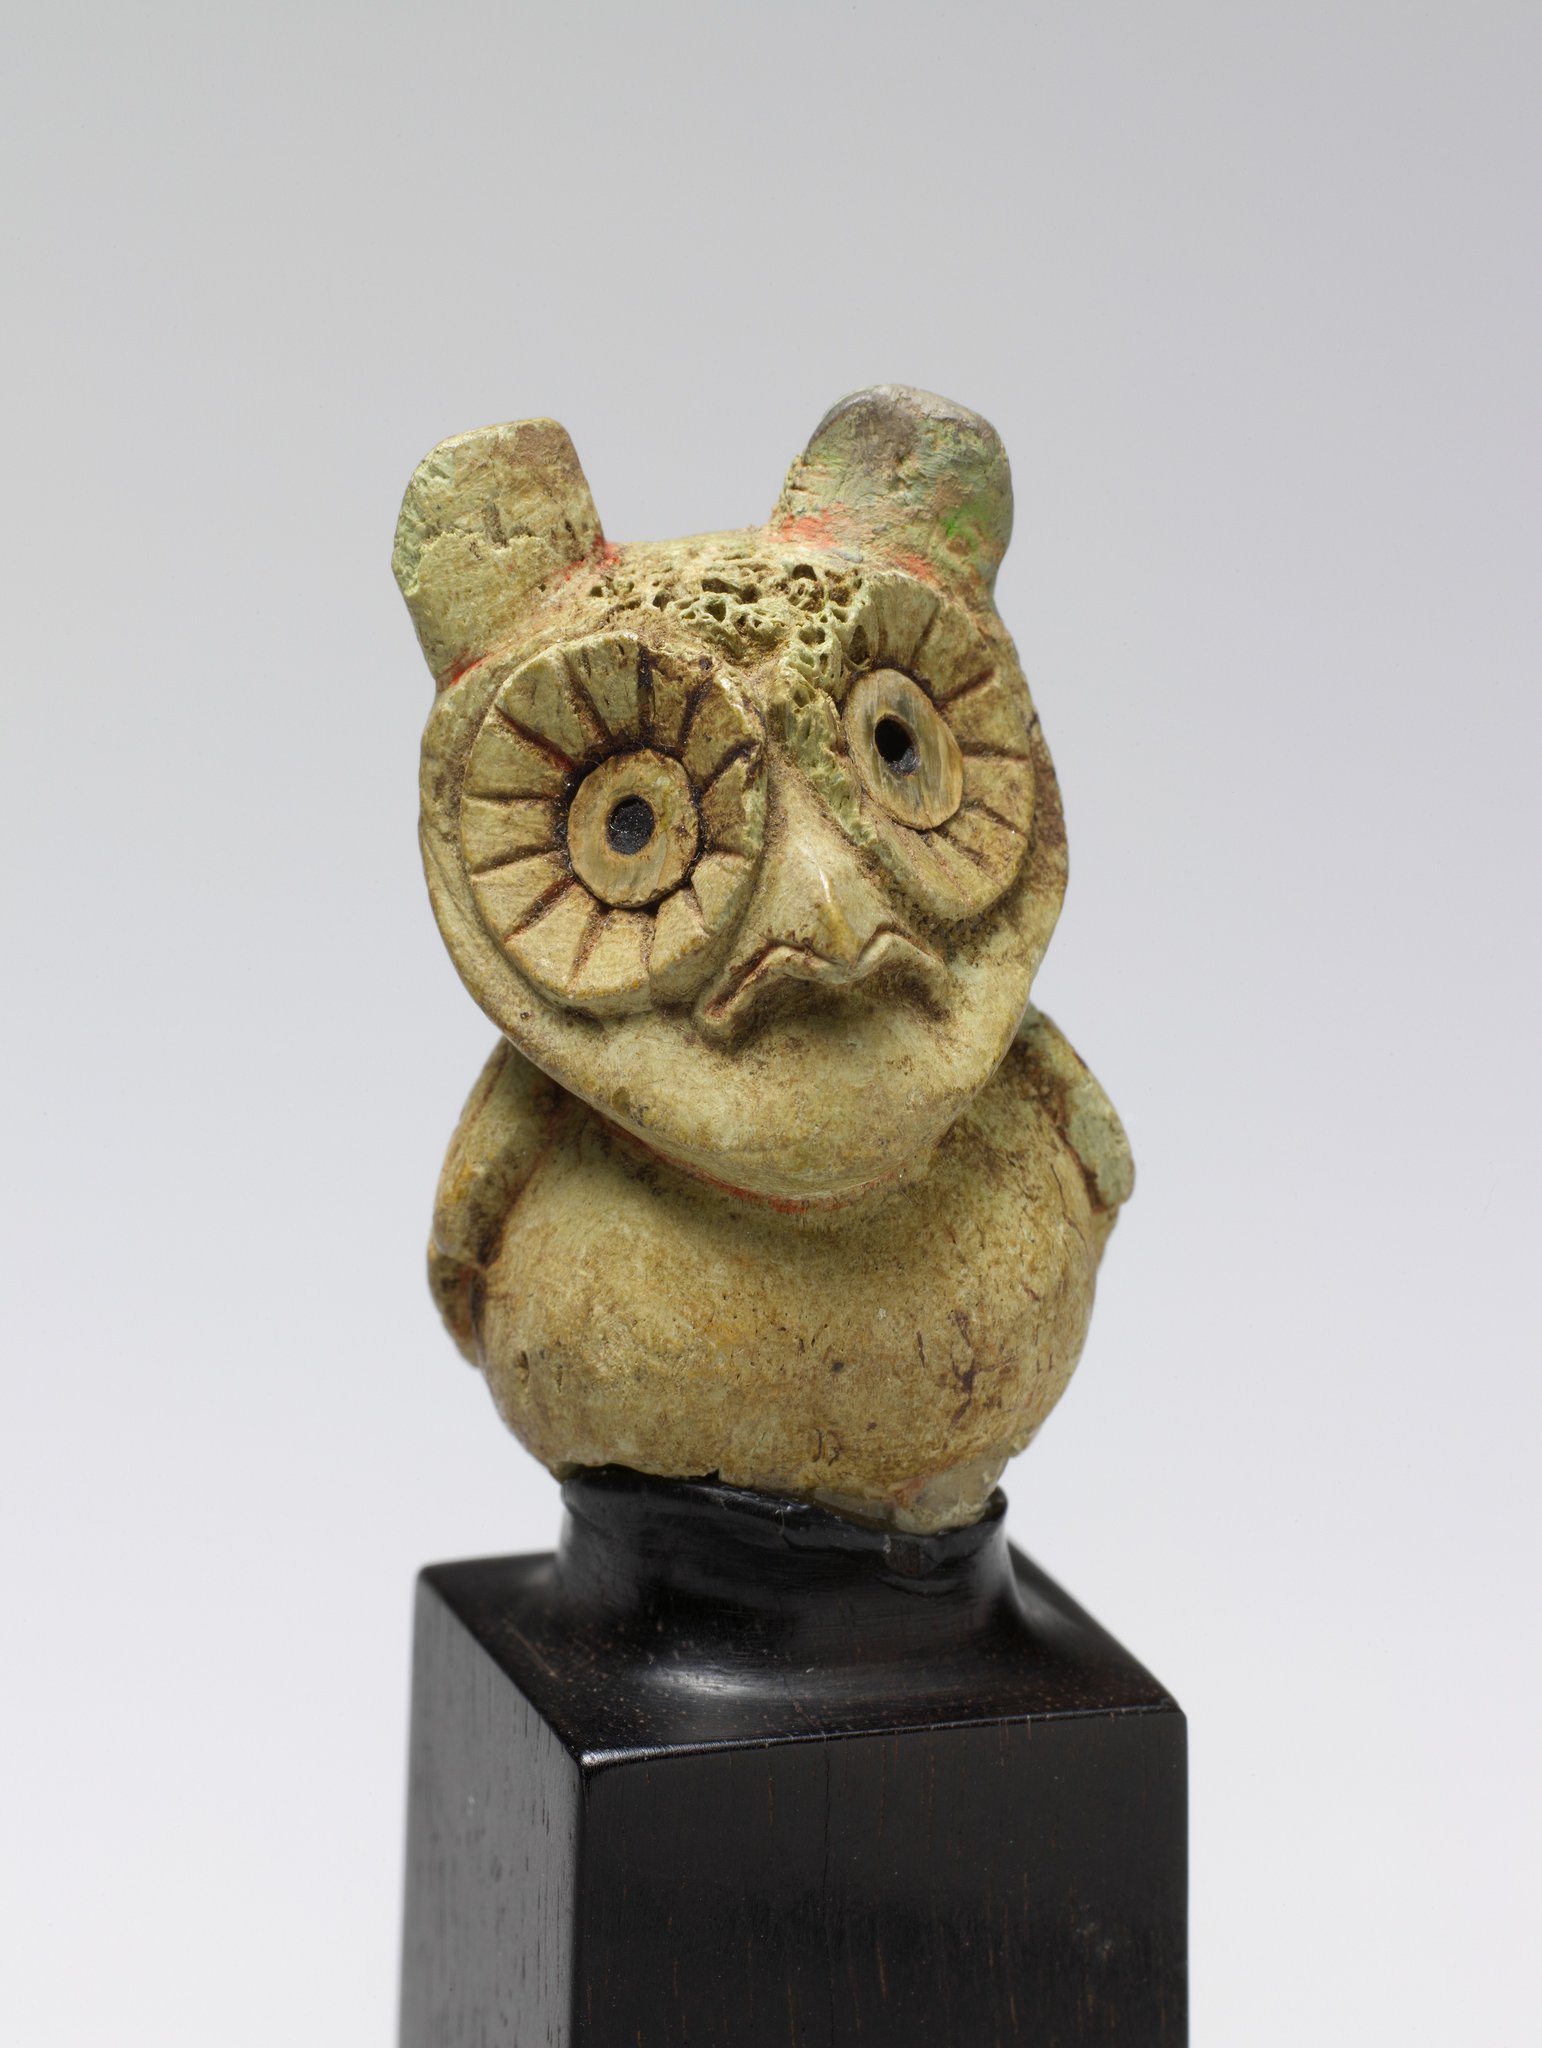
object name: figure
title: Figure of an Owl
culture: moche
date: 201-600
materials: bone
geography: peru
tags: owls